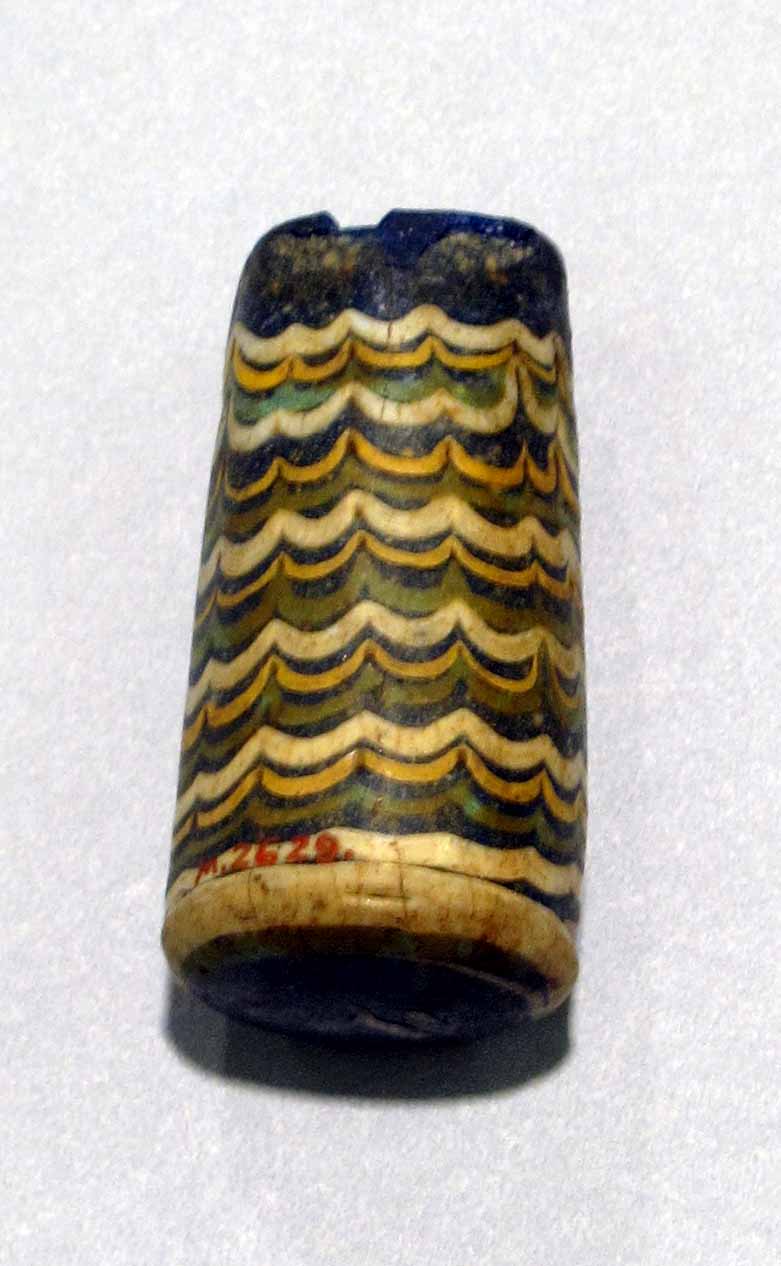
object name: kohl tube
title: Kohl Tube in the form of a Palm Column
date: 1550-1295 BCE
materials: glass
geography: egypt